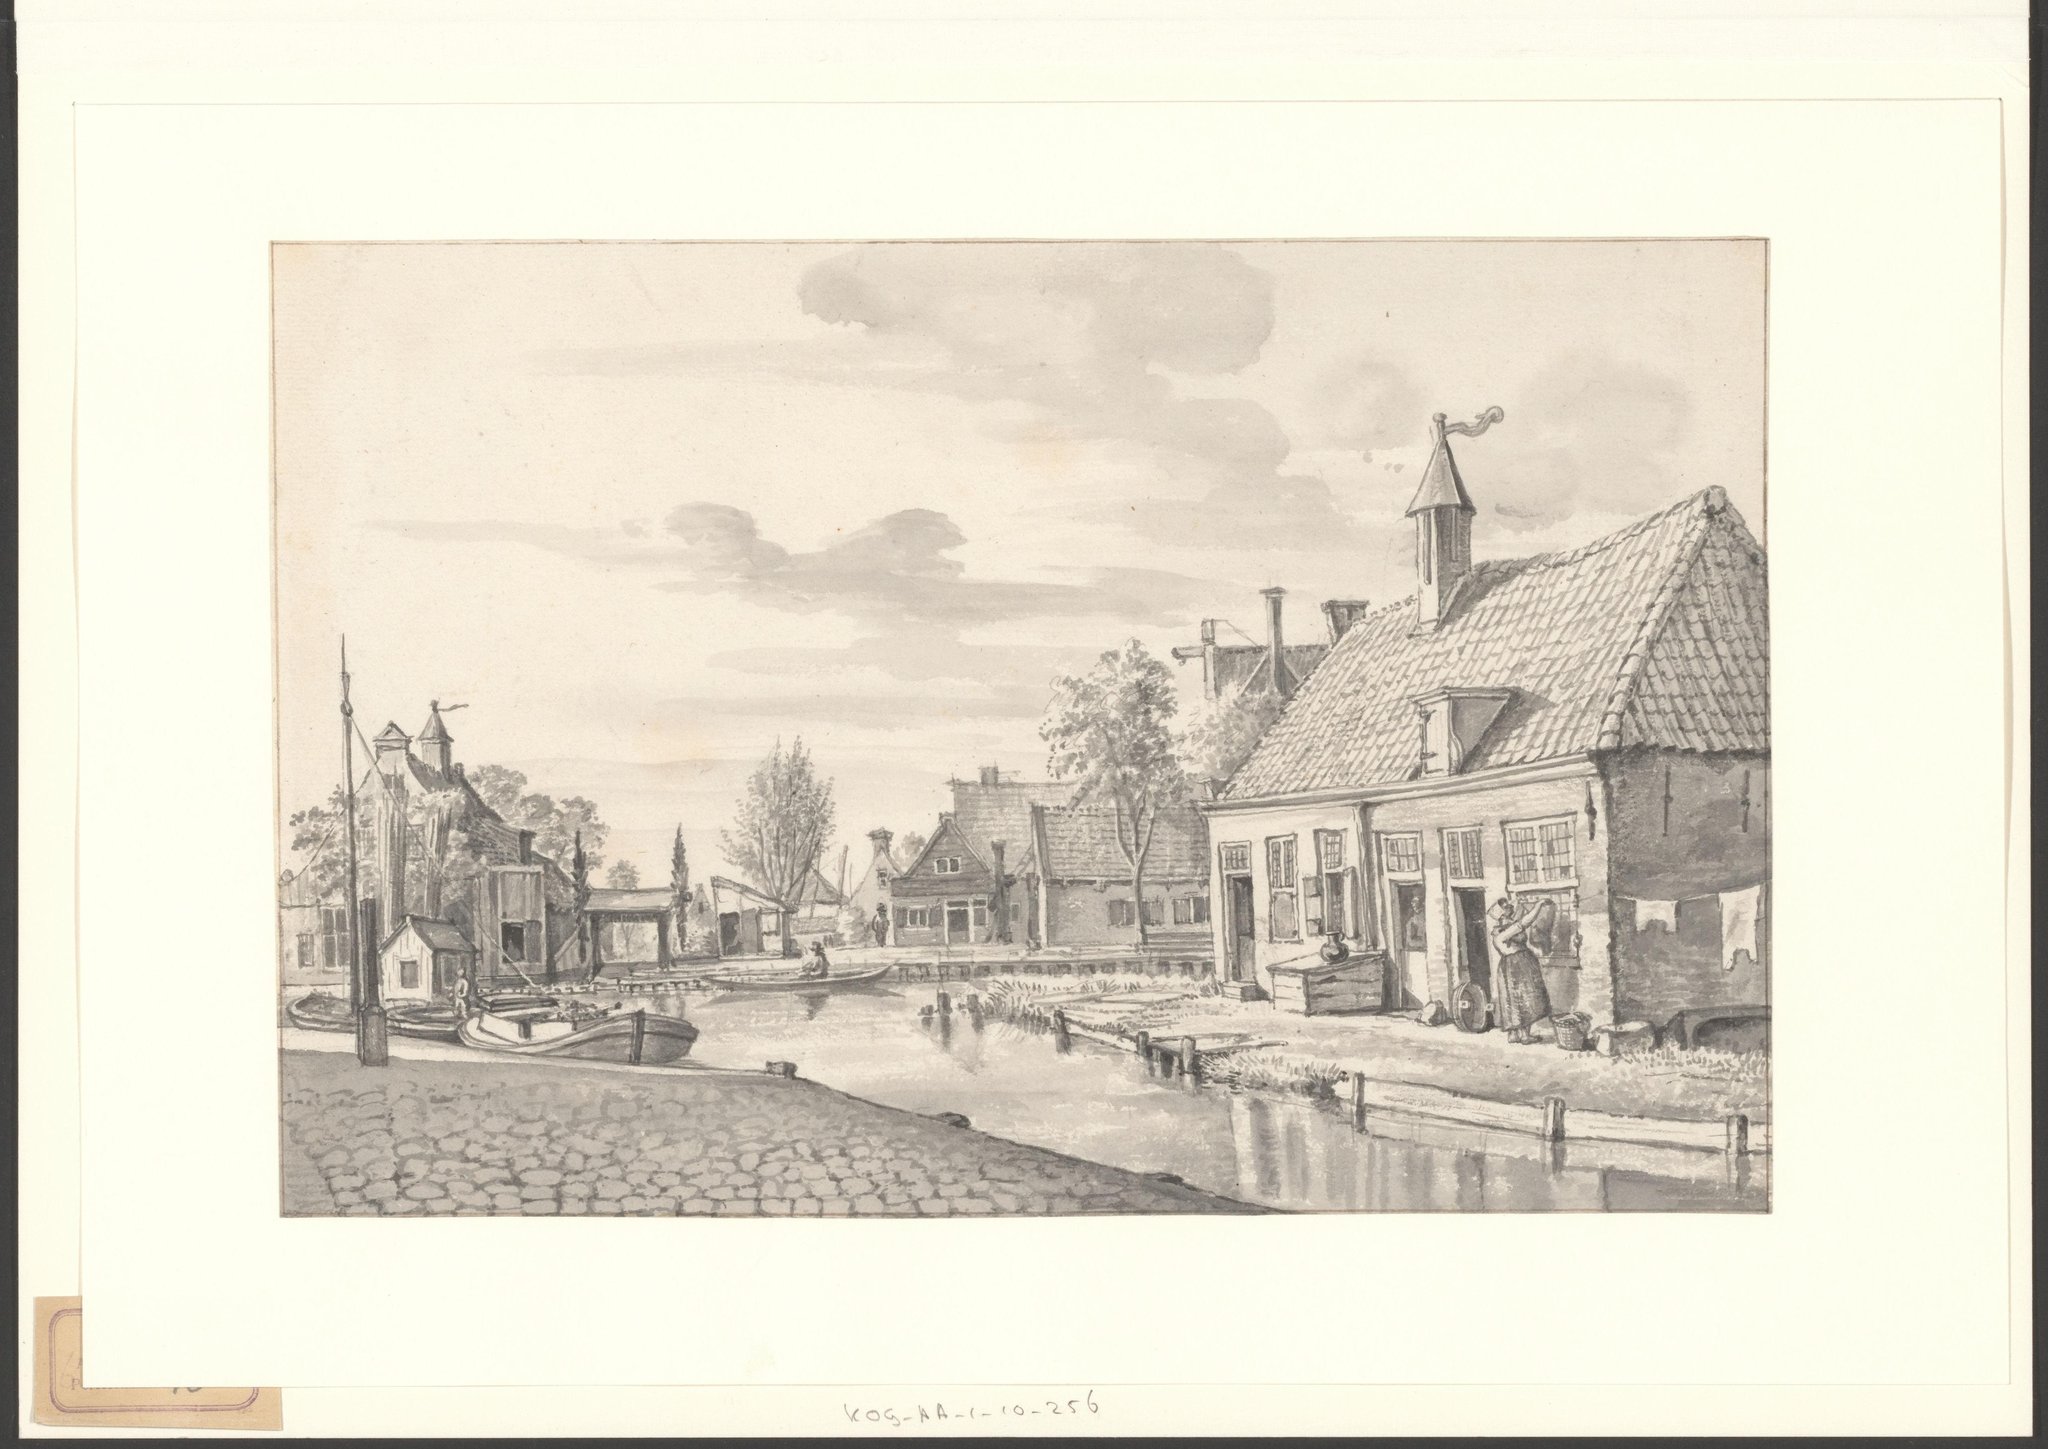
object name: drawing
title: Gezicht op de overhaal aan het einde van de Overtoom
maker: gerrit lamberts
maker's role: bookseller, draughtsman, print maker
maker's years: 1776-1850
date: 1817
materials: ink, paper, pencil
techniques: brush, pen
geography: amsterdam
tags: city-view in general; 'veduta', canal, rolling bridge (dutch: 'overtoom'), the usual house or row of houses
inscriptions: signature, date and inscription: ‘Gezigt van de overhaal / van het end van den overtoom. / G. Lamberts. 1817.’, inscription: ‘Port. 10-256’, collector's mark: ‘10’ Lugt 1641b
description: Onderwerpsrubriek binnen de Atlas Amsterdam: Overtoom.